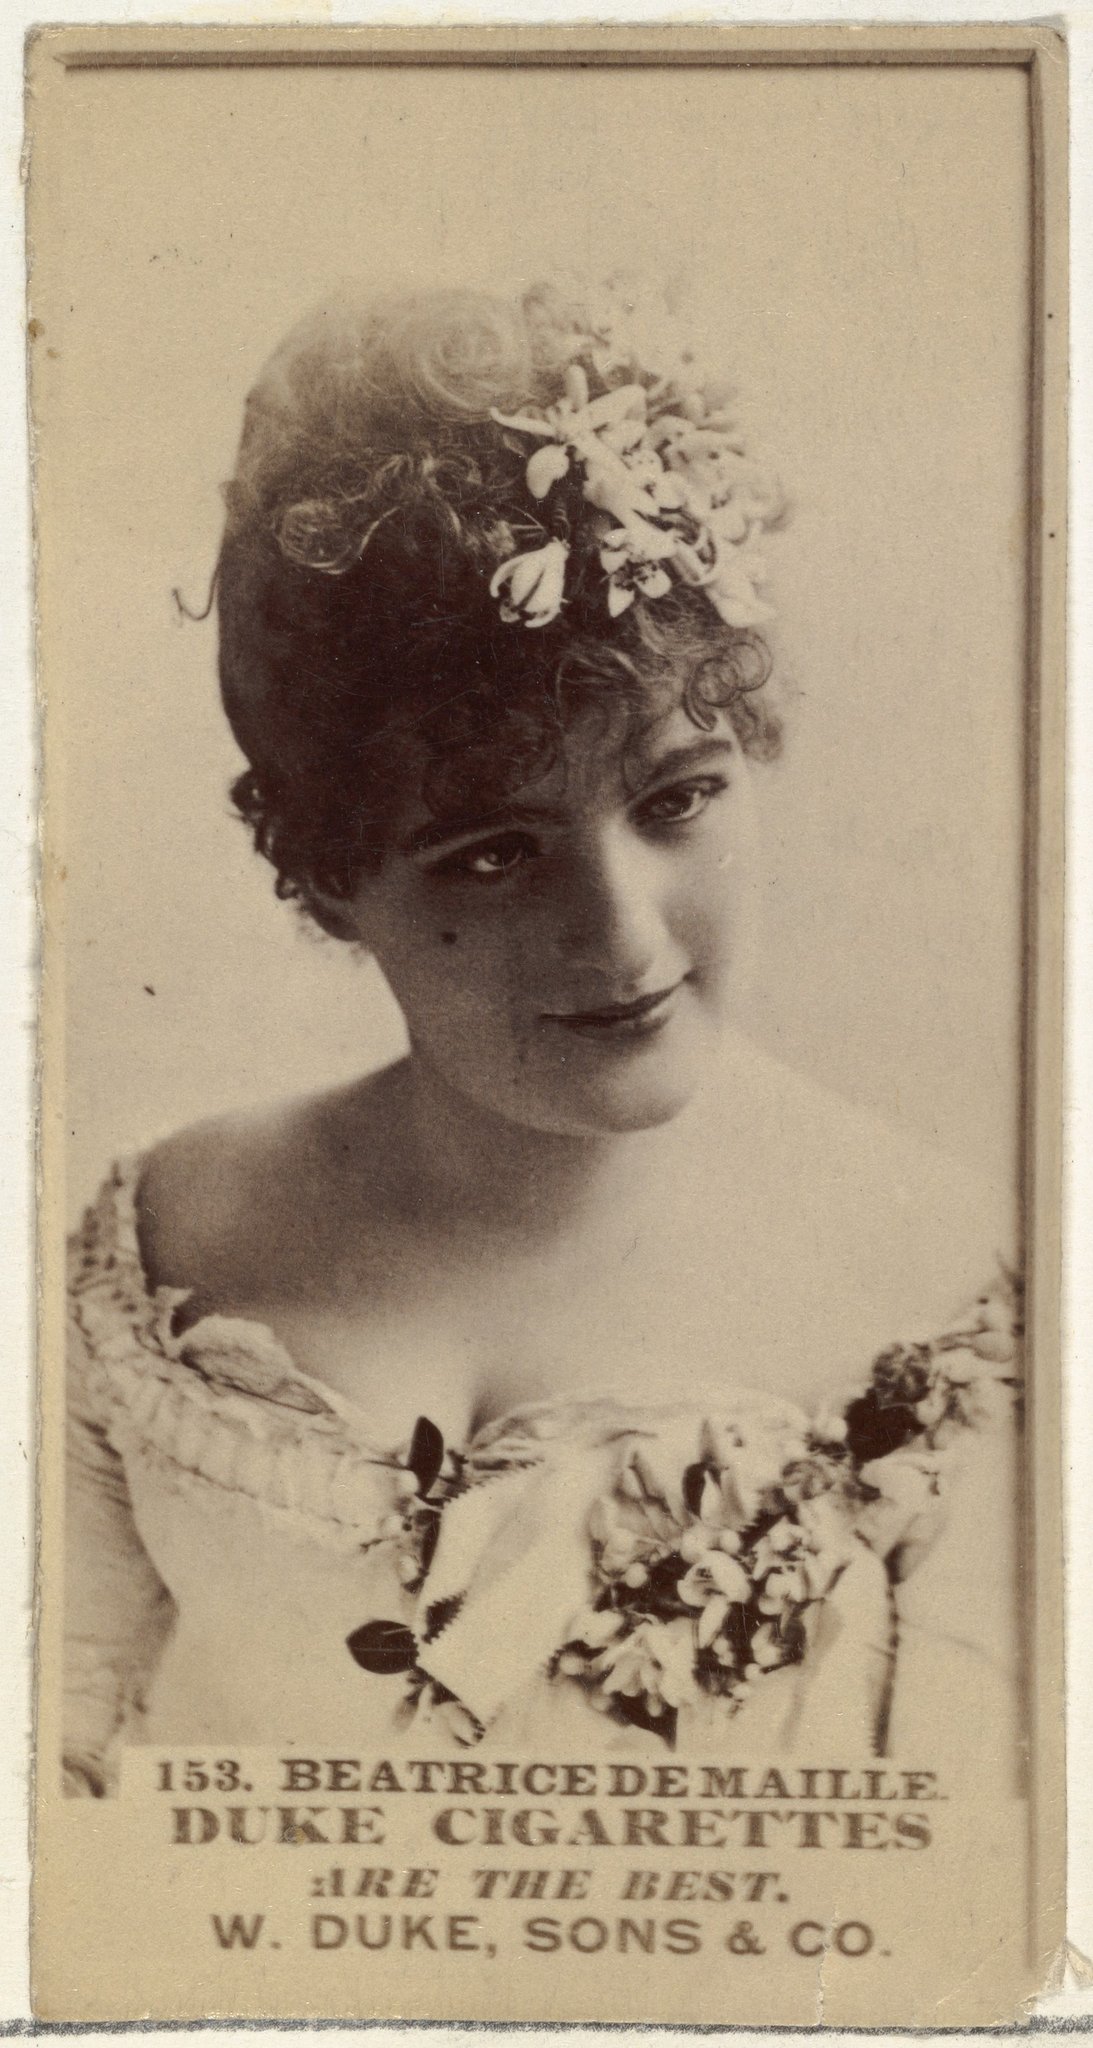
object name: photograph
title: Card Number 153, Beatrice De Maille, from the Actors and Actresses series (N145-7) issued by Duke Sons & Co. to promote Duke Cigarettes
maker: w. duke, sons & co.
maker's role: publisher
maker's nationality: american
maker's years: 1870-1920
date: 1880-1889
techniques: albumen silver print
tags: portraits,women,actresses